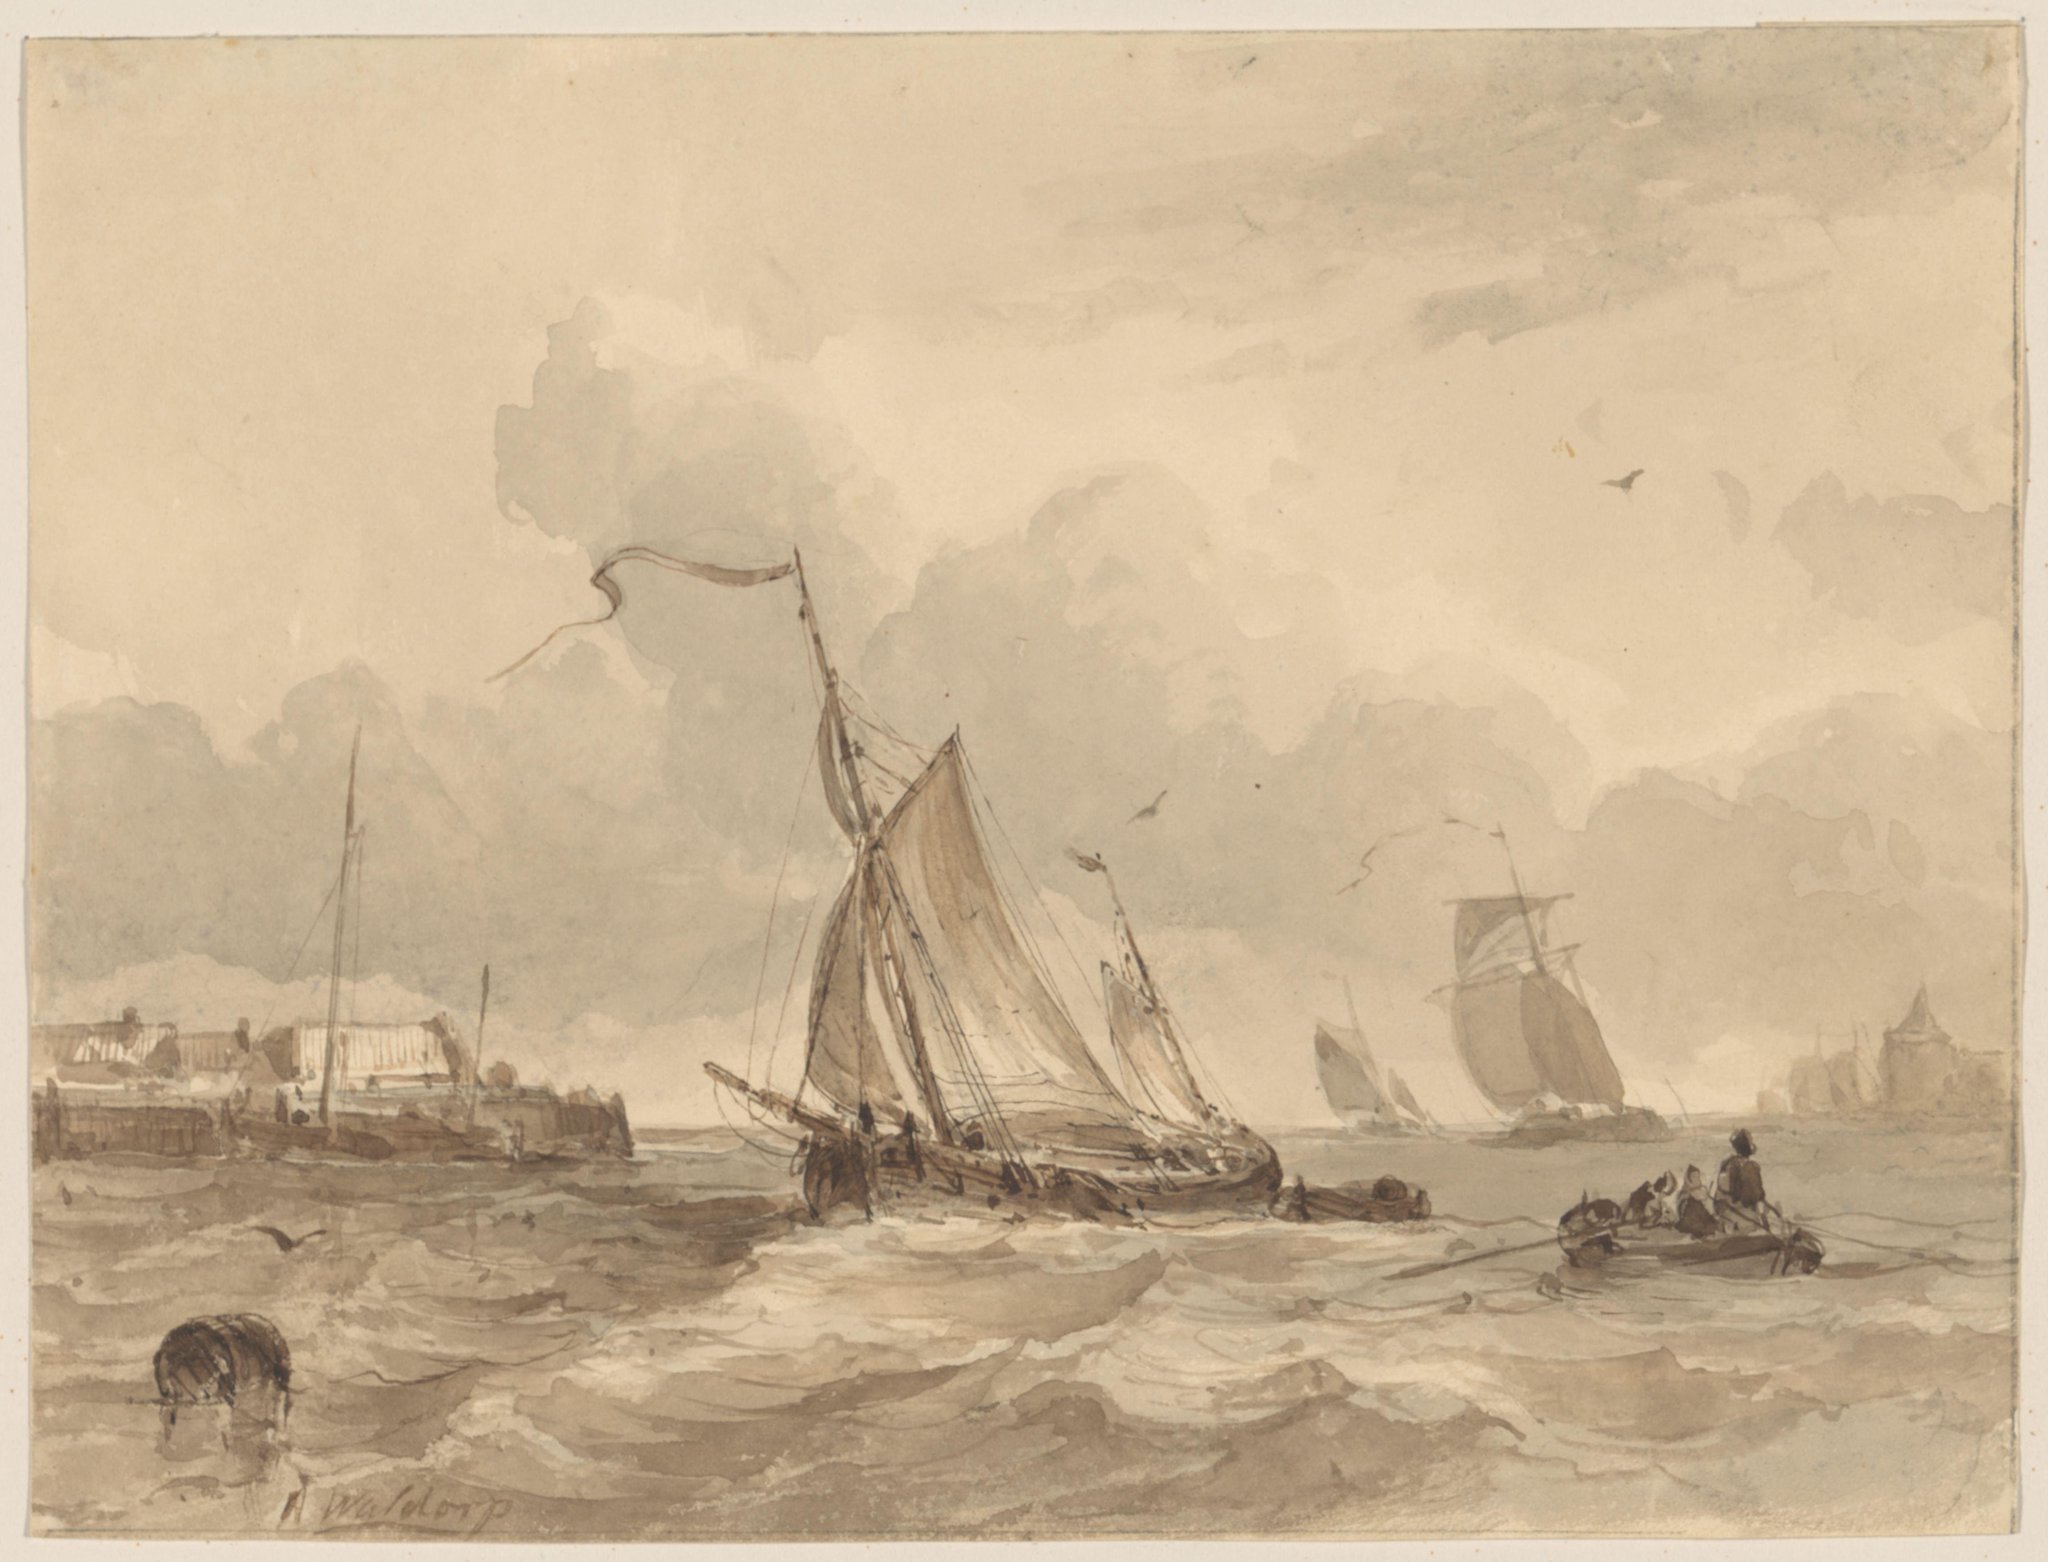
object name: drawing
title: Zeehaven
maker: antonie waldorp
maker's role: draughtsman, painter, print maker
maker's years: 1803-1866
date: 1813-1866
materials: ink, paper, pencil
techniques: brush, pen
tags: sailing-ship, sailing-boat, sea (seascape)